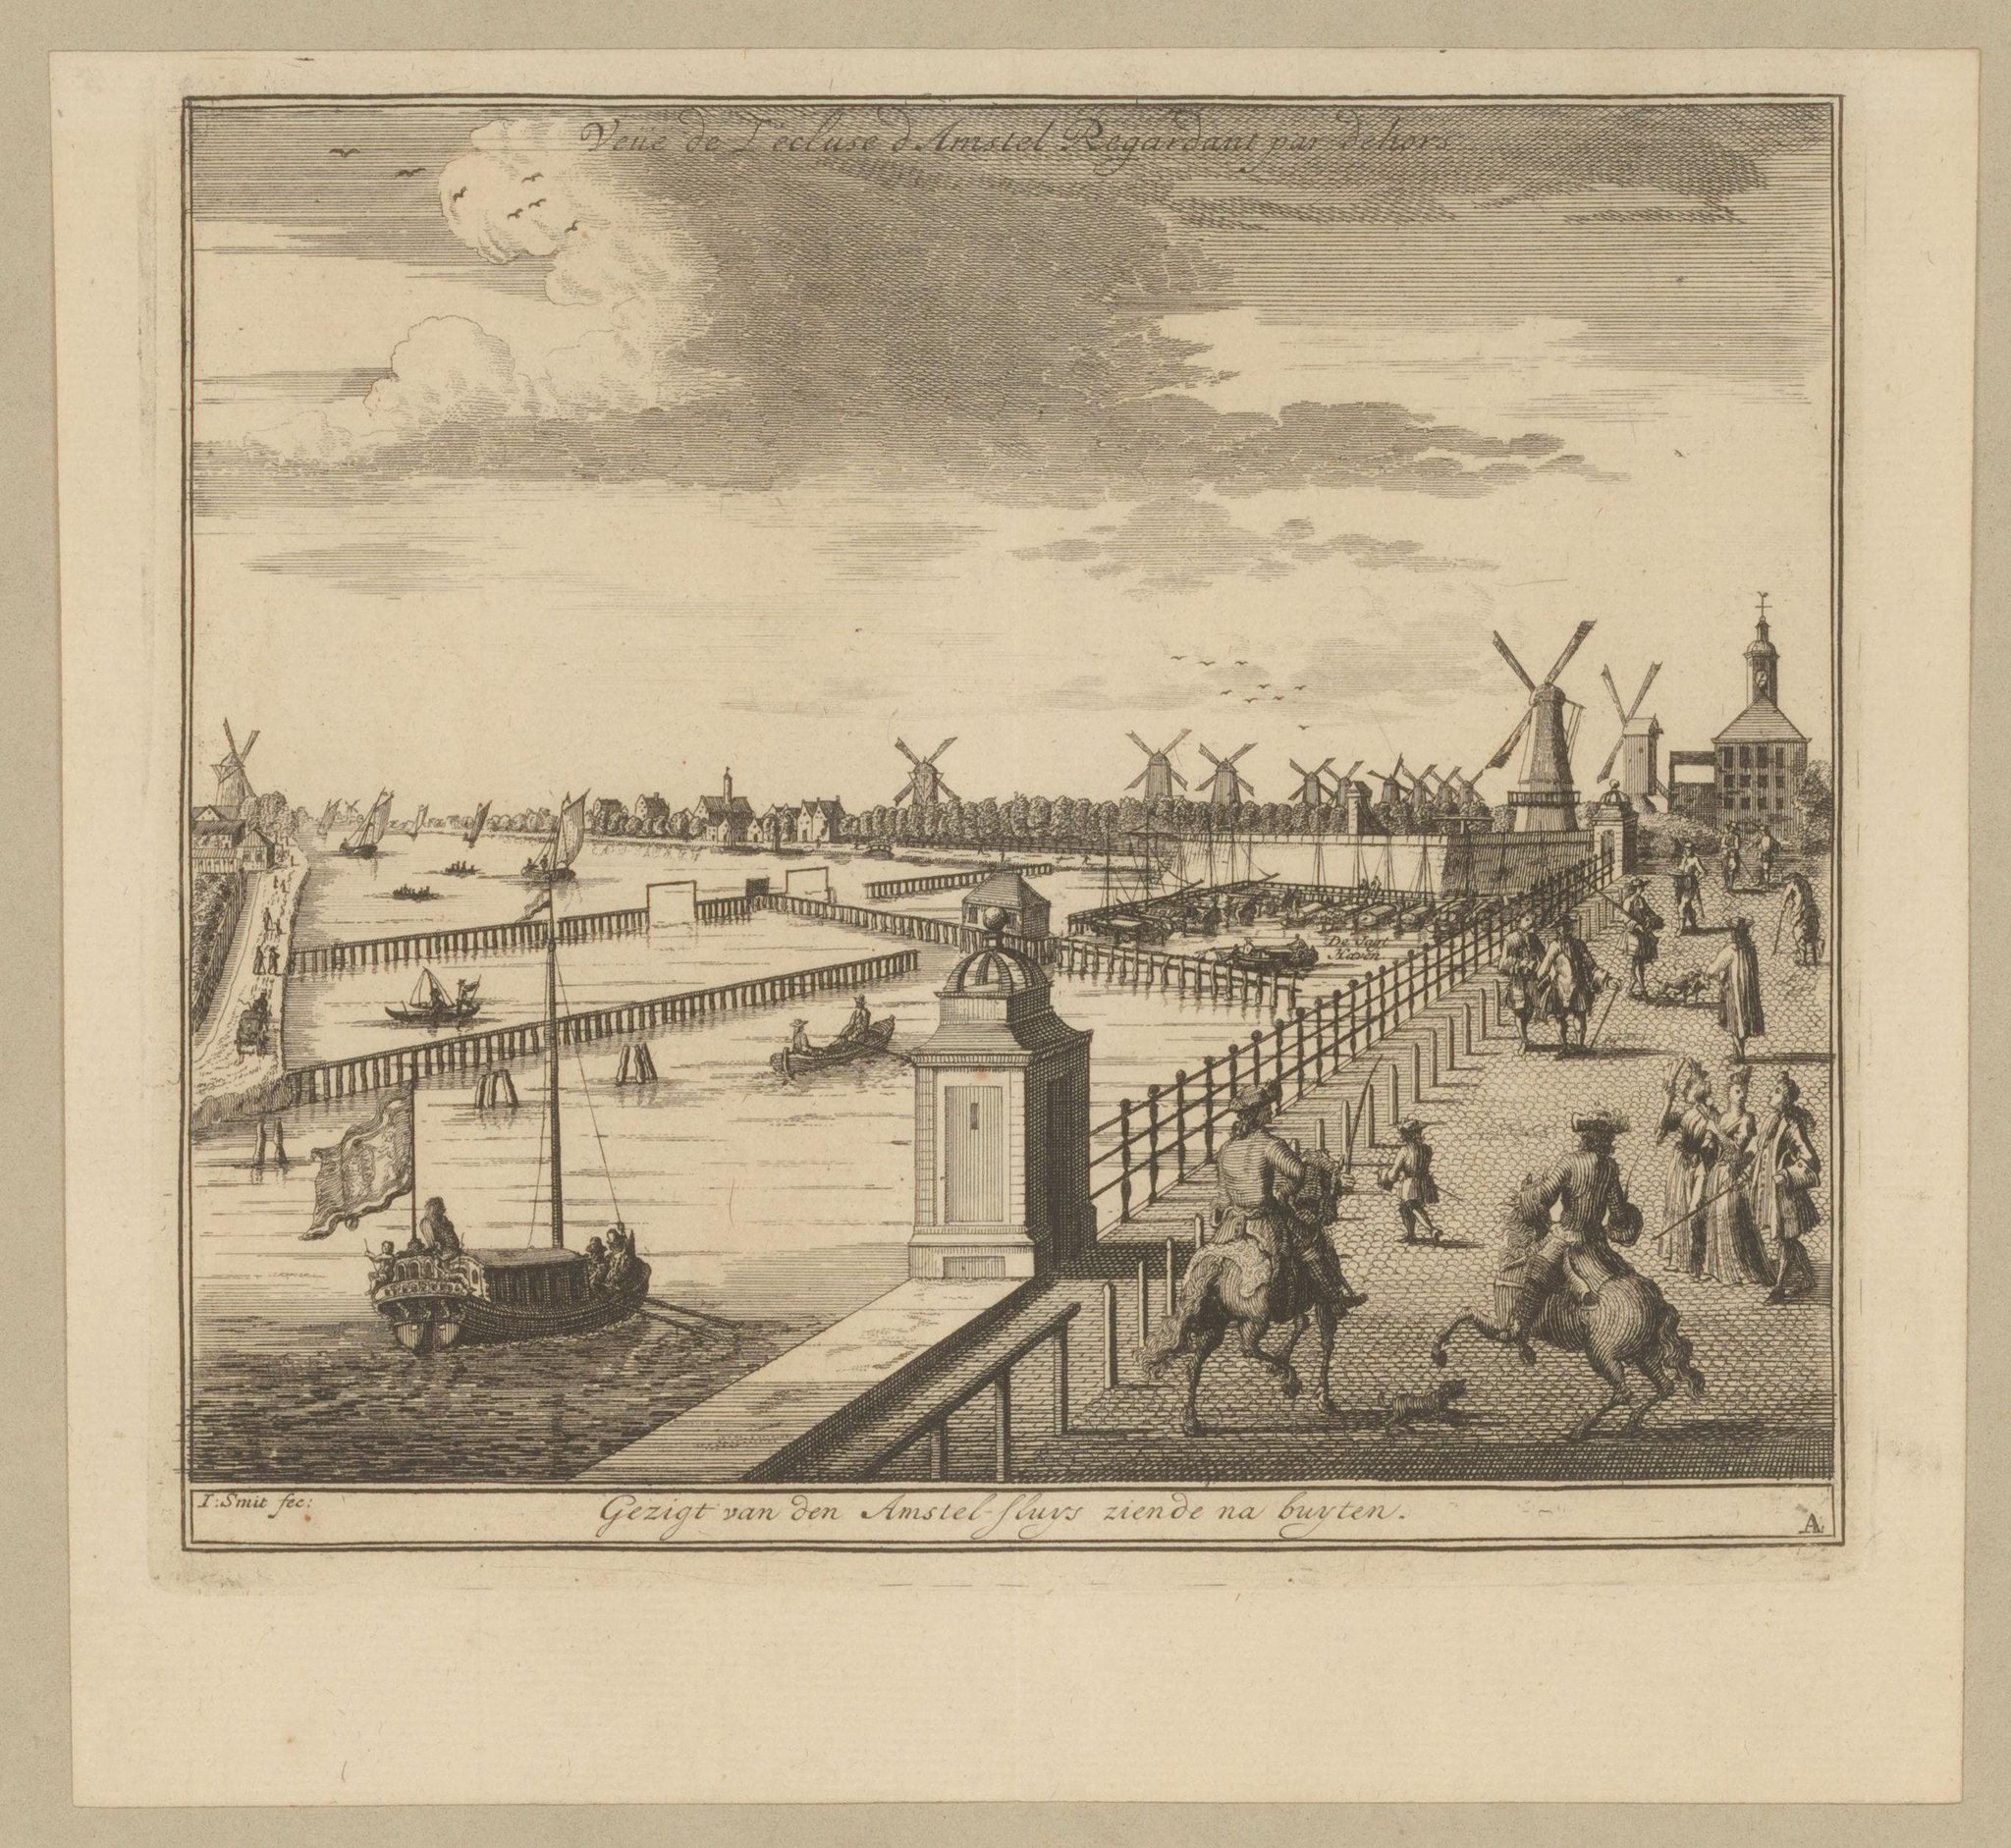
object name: print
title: Gezicht op de Binnen-Amstel en de Hogesluis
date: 1685-1748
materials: paper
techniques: engraving, etching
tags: city-view in general; 'veduta', river, windmill in landscape, bridge in city across river, canal, etc.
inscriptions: collector's mark: ‘4’ Lugt 1641b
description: Onderwerpsrubriek binnen de Atlas Amsterdam: Amstel van Hogesluis stroomopwaarts. Rechtsonder: A.